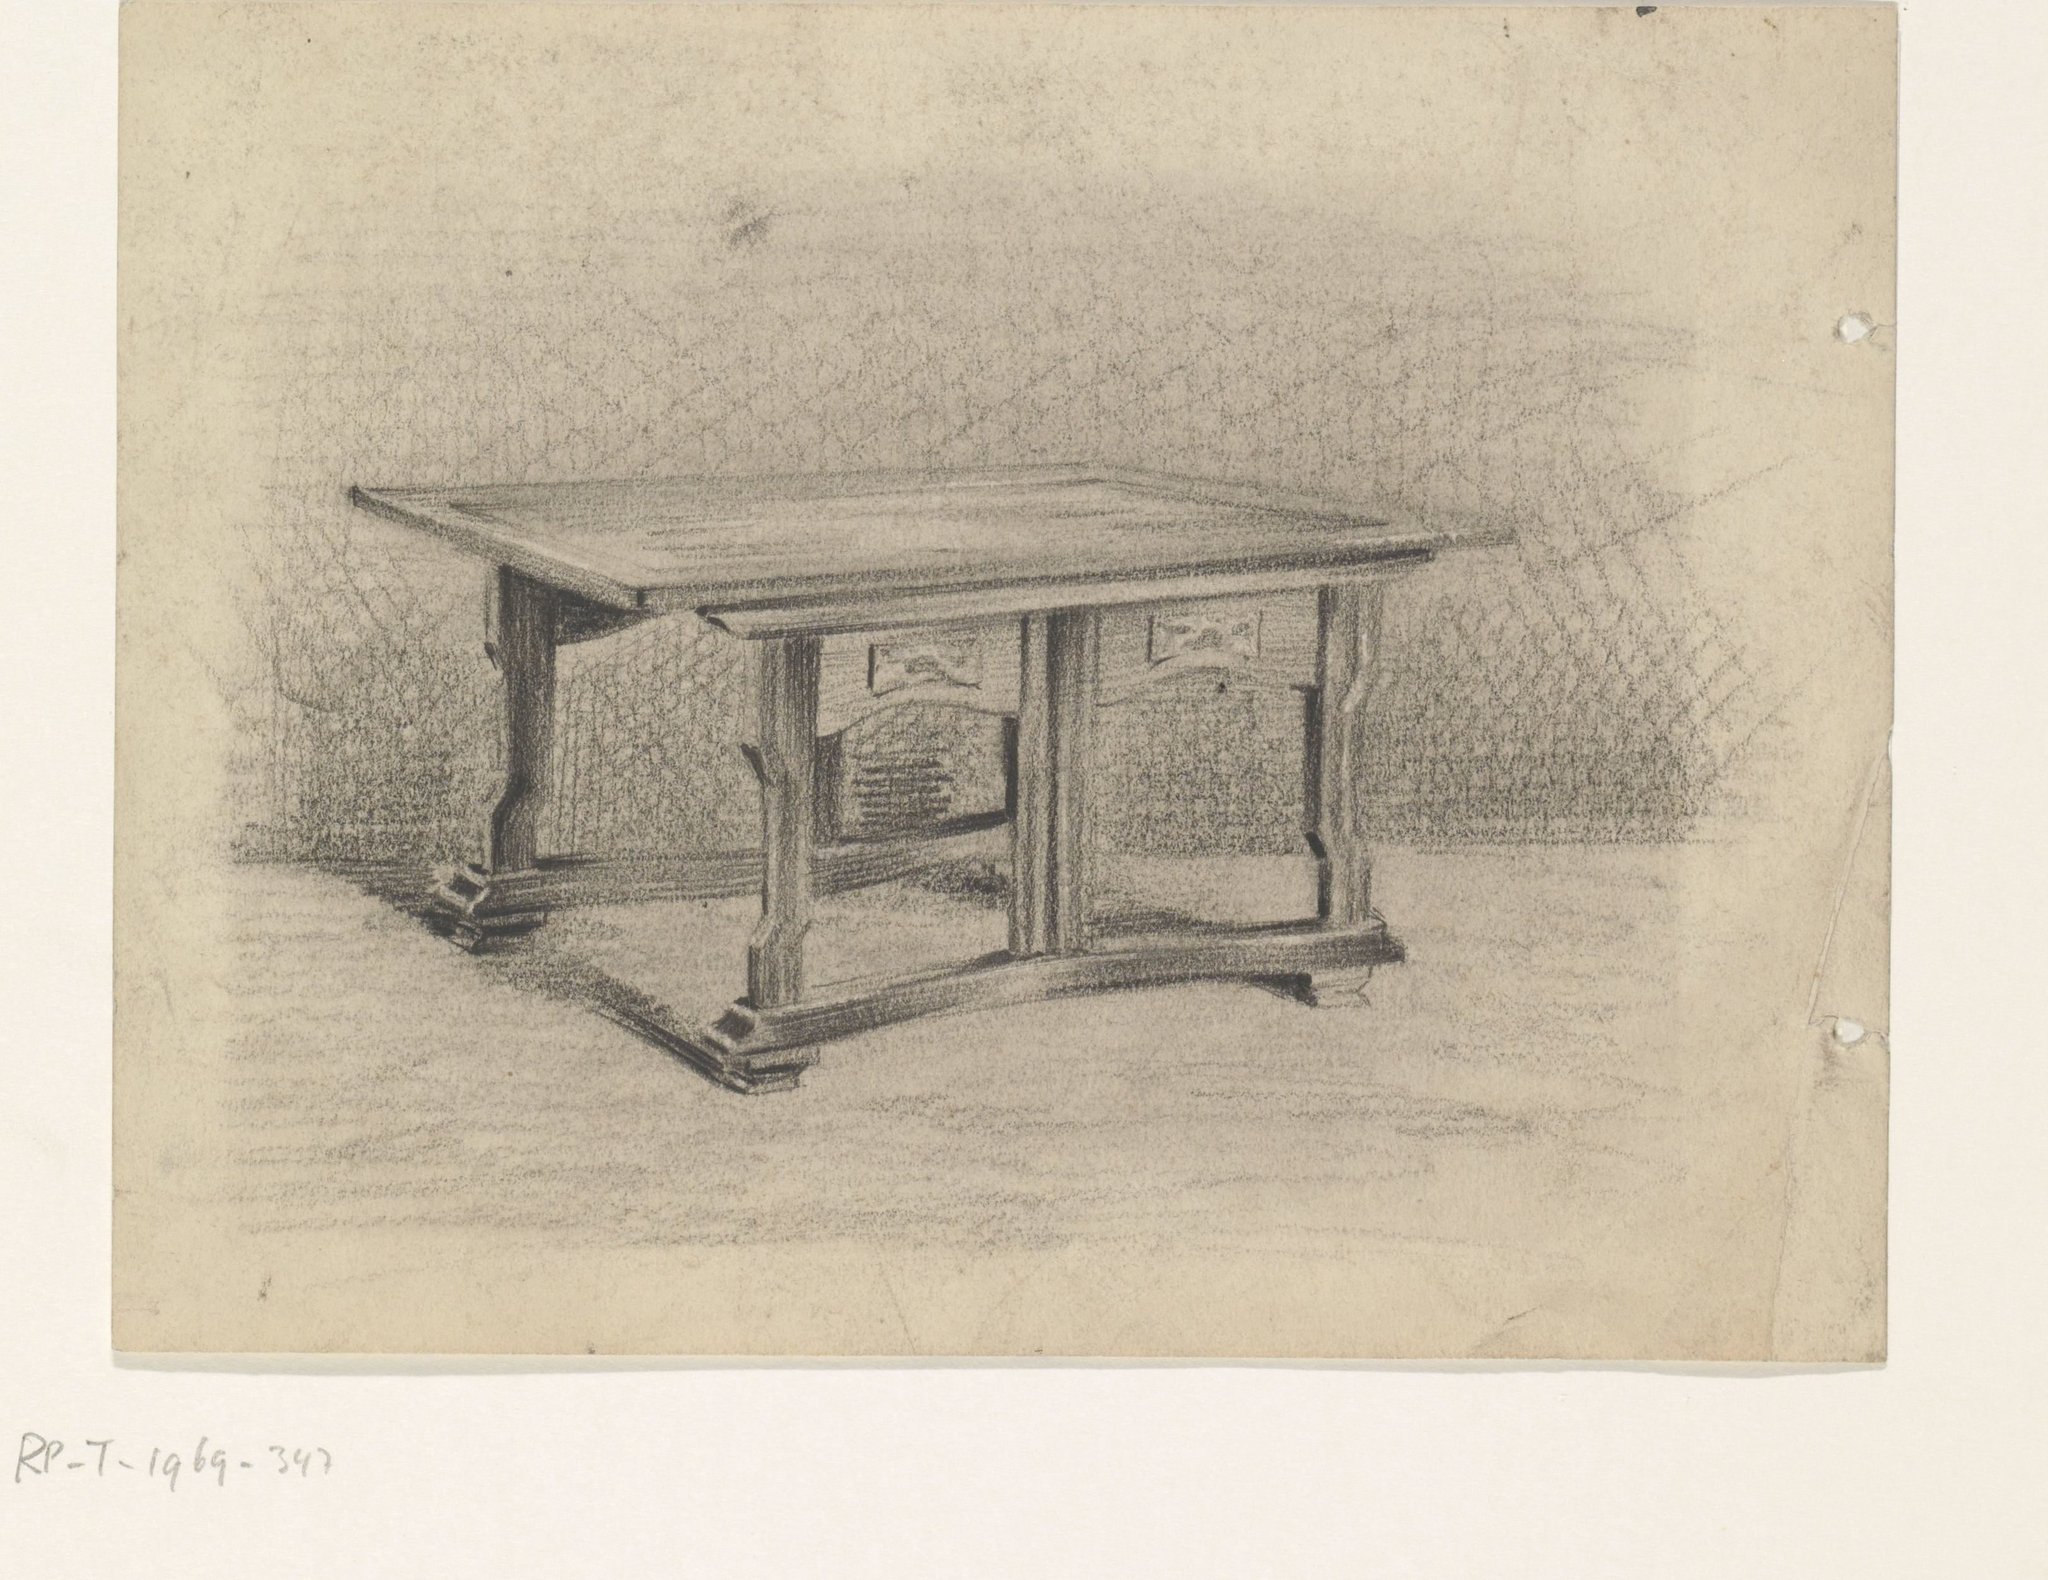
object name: drawing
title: Ontwerp voor een tafel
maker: carel adolph lion cachet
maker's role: draughtsman, print maker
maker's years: 1864-1945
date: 1874-1945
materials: chalk, paper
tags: table